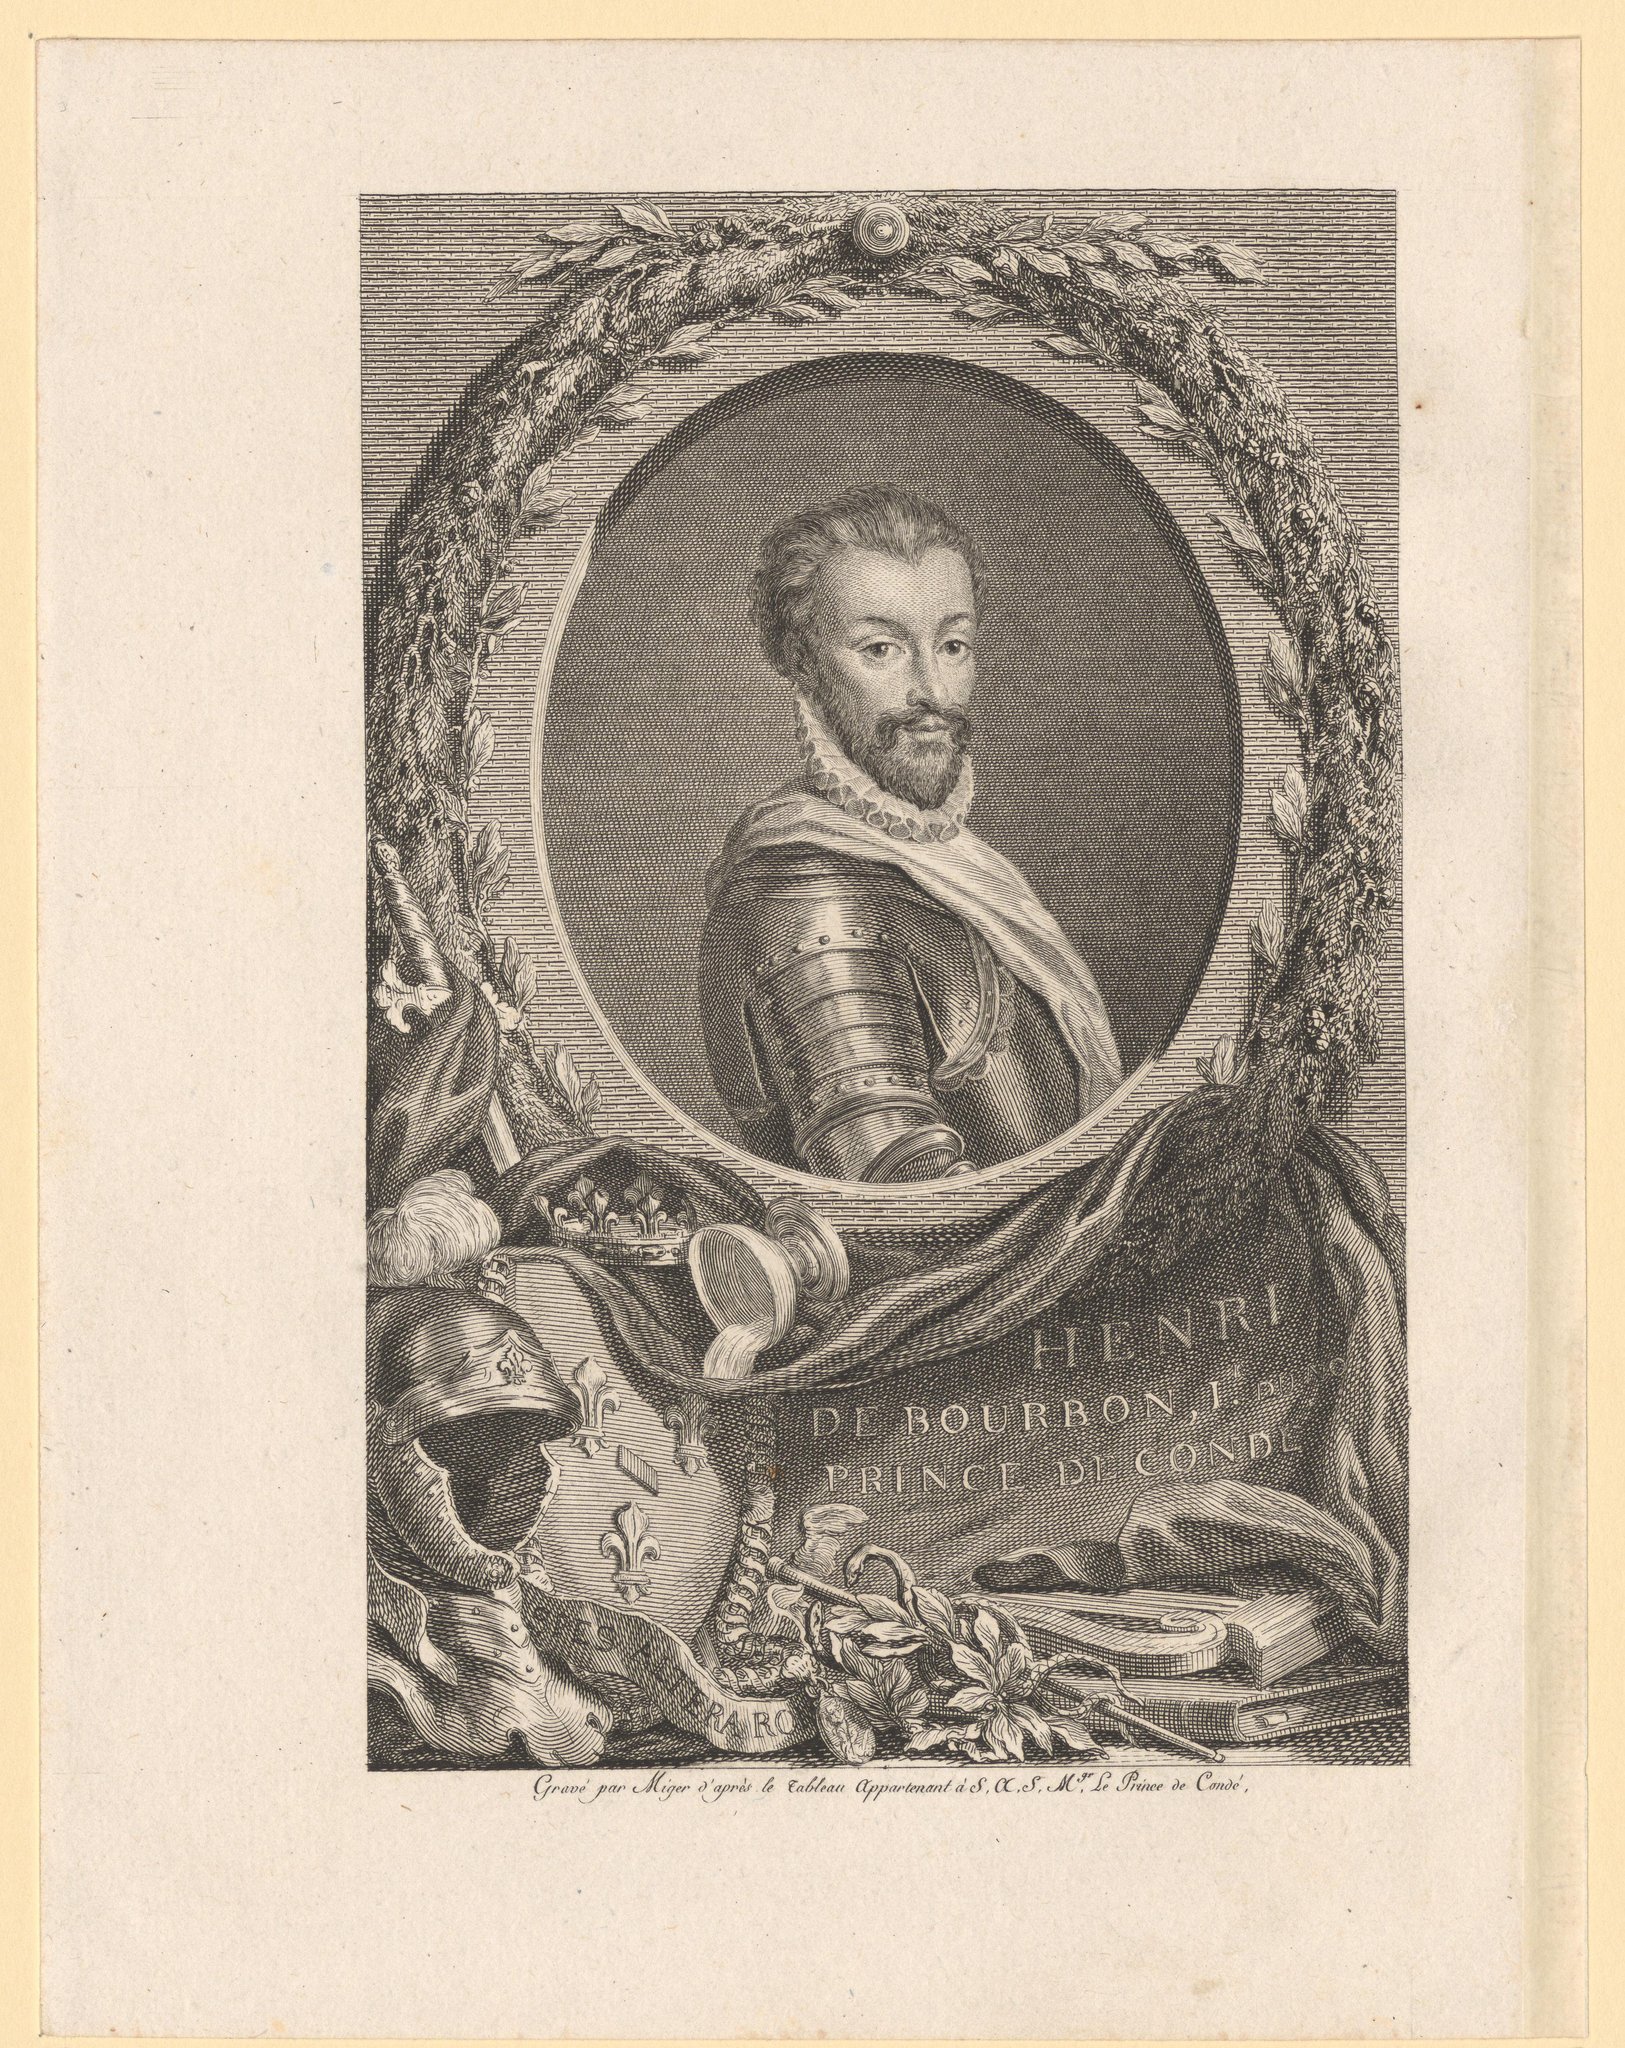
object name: print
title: Portret van Hendrik I de Bourbon-Condé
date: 1786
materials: paper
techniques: engraving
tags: historical persons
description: Prent waarschijnlijk uit: Desormeaux, M. Histoire de la maison de Bourbon (...). Parijs: L'Imprimerie Royale, 1786, dl. 4.